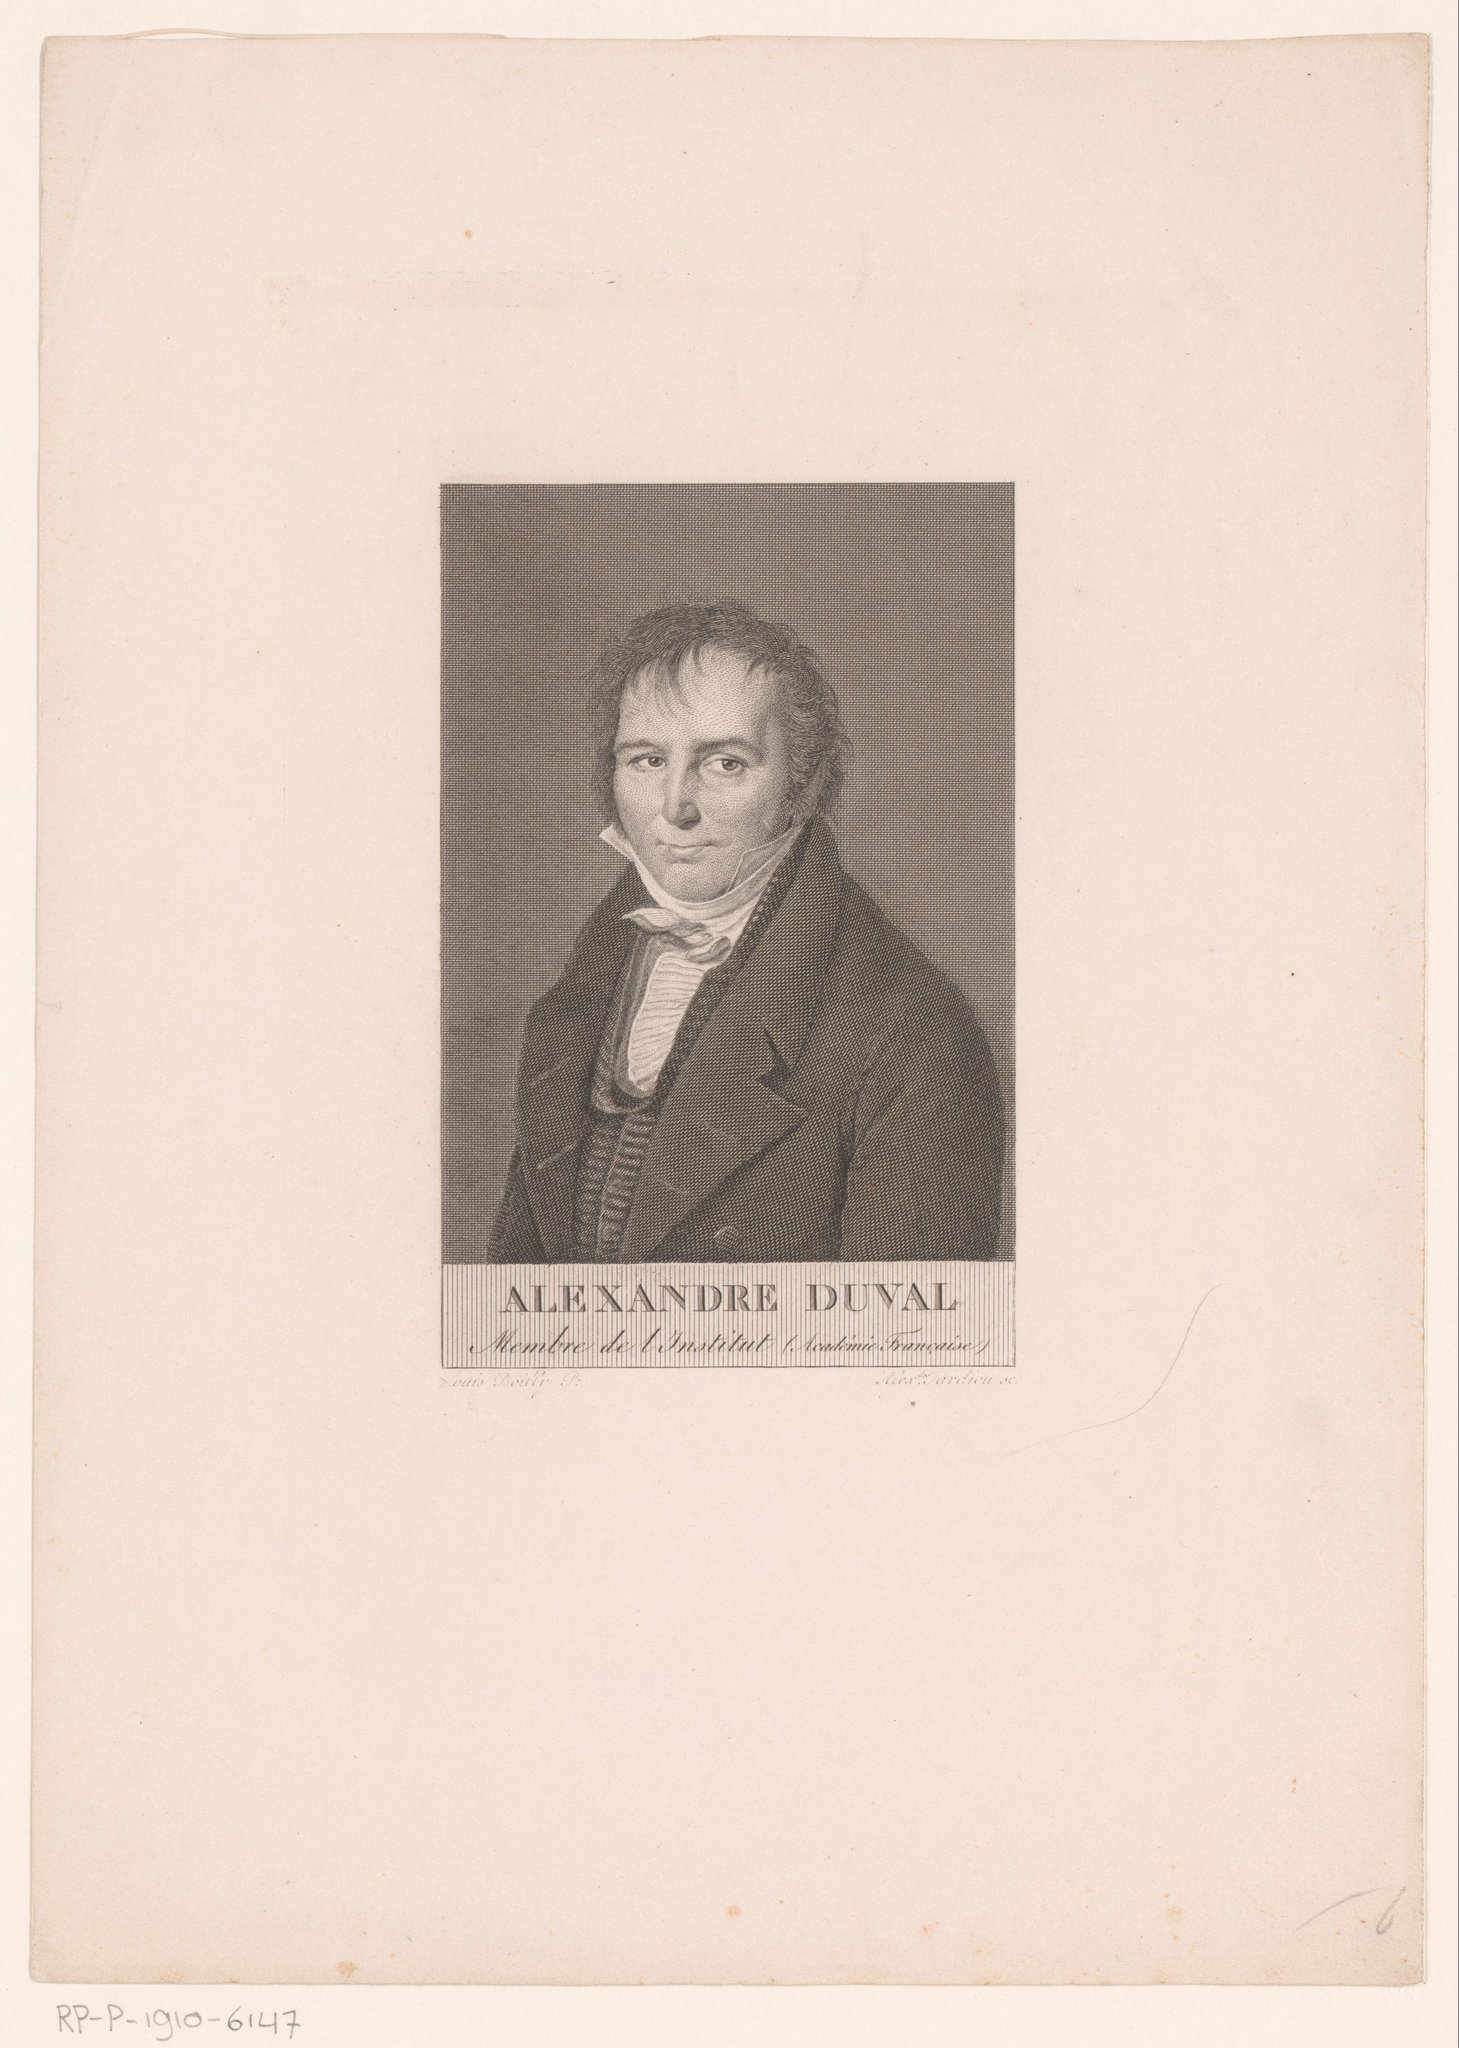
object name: print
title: Portret van Alexandre Duval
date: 1771-1844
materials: paper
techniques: engraving, etching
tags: paris, historical persons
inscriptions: collector's mark: Lugt 2228